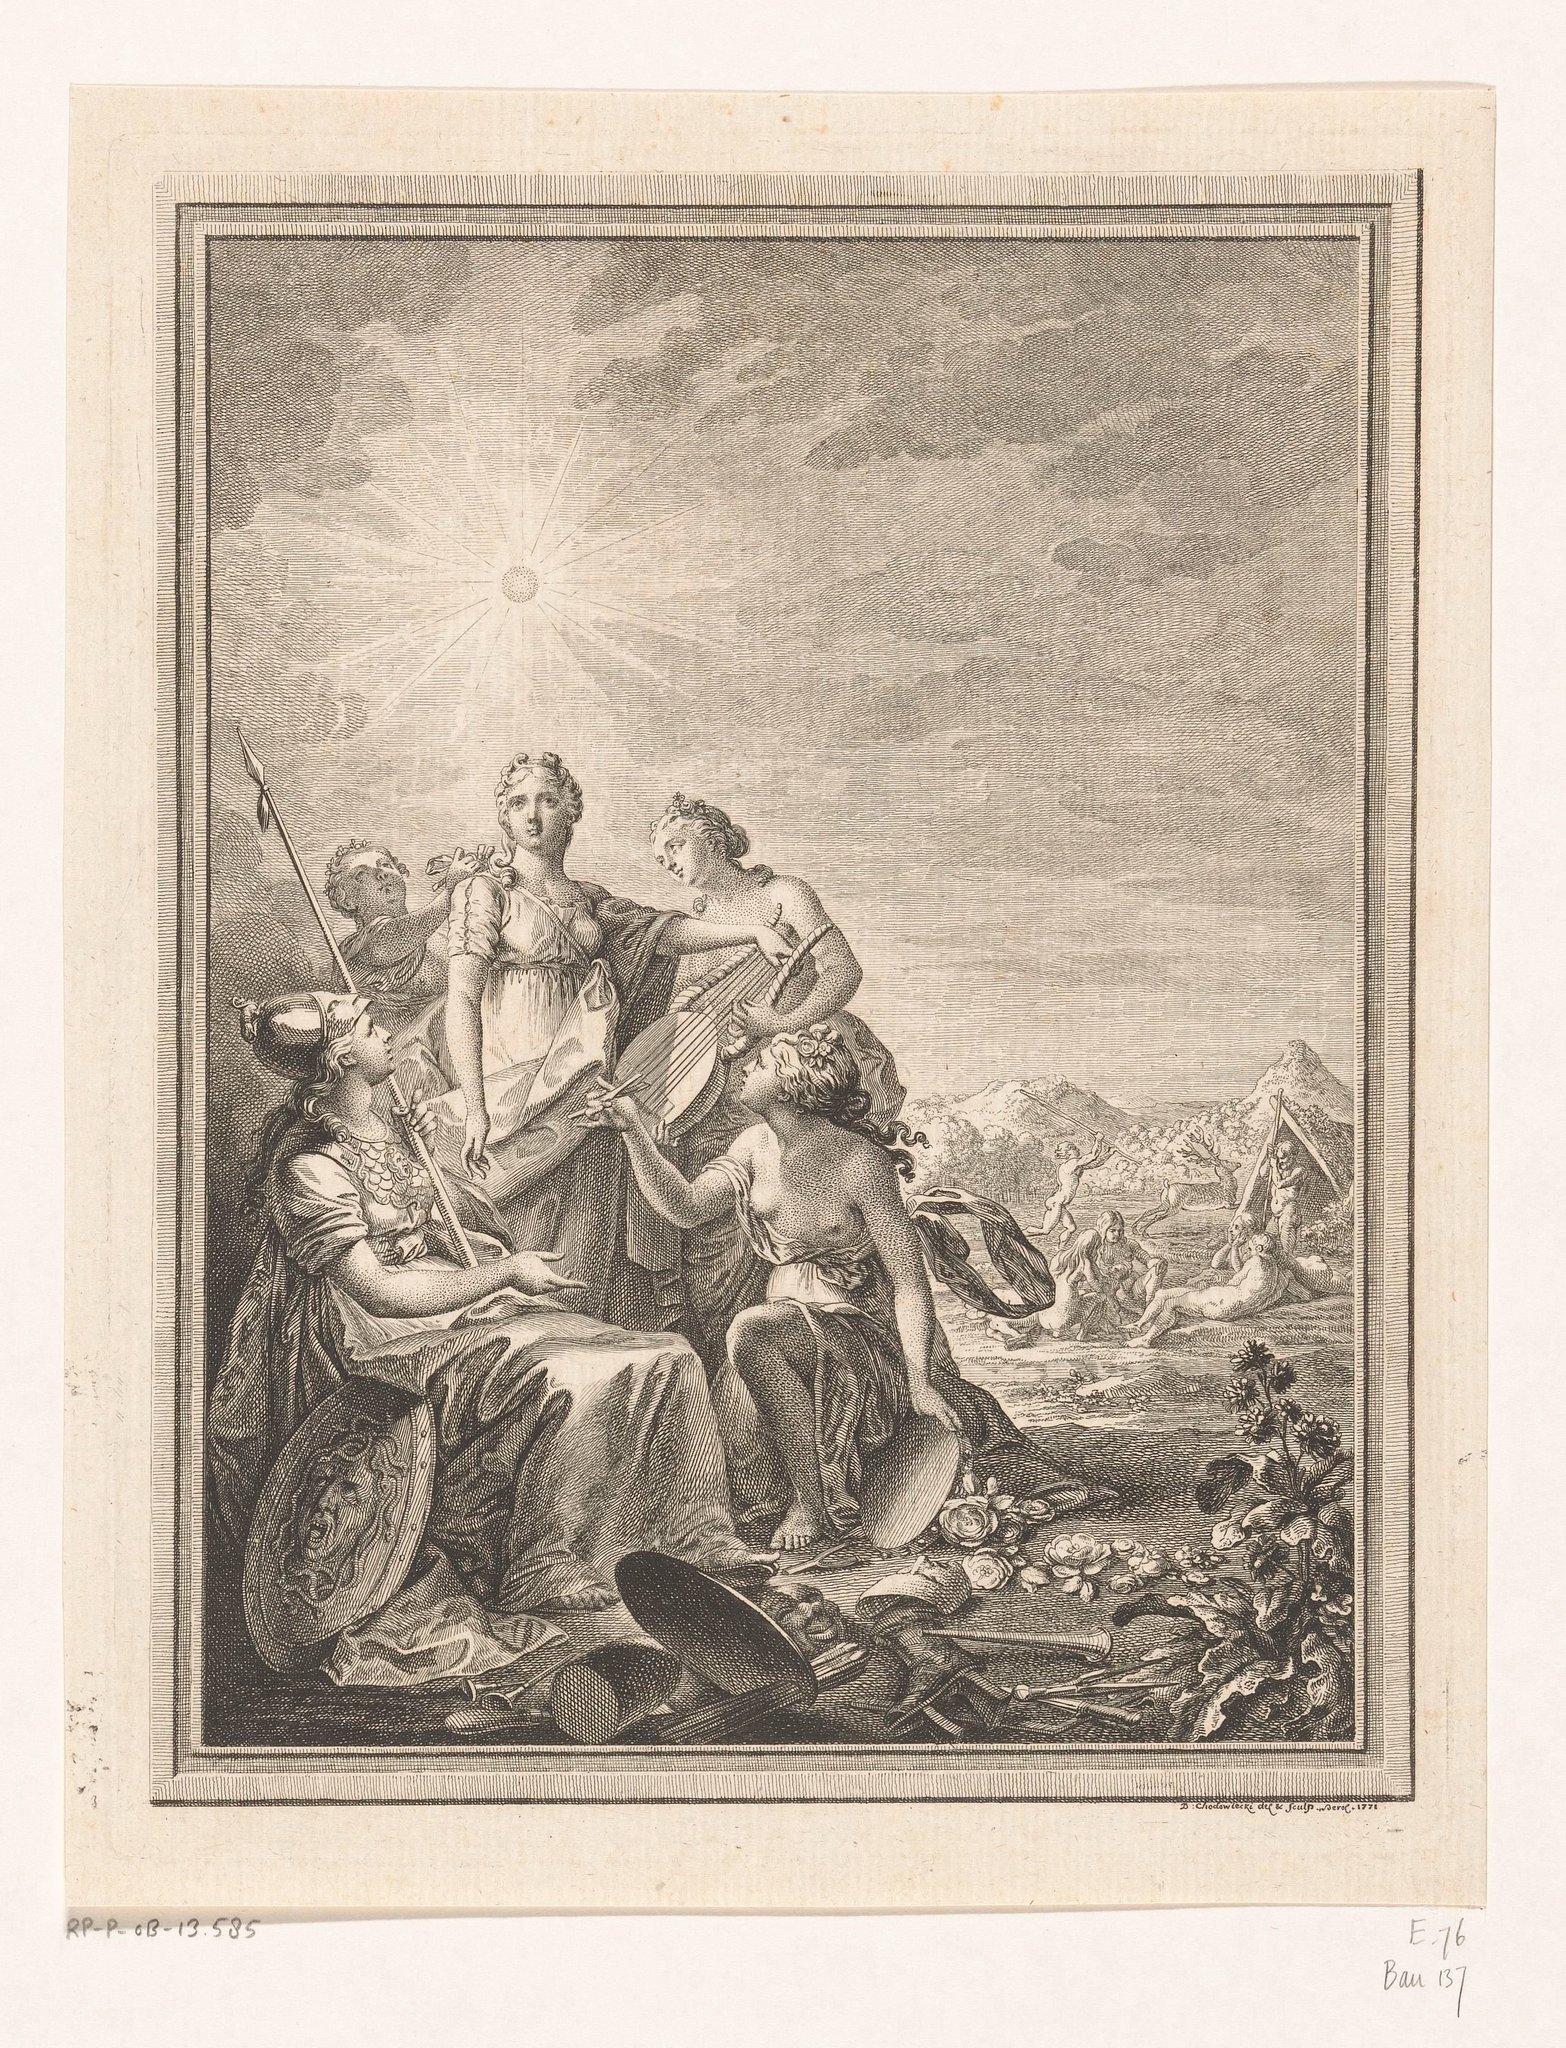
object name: print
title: Schoonheid met Minerva en de drie gratieën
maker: daniel nikolaus chodowiecki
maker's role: draughtsman, print maker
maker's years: 1726-1801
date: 1771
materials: paper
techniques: etching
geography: berlin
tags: (story of) diana (artemis), stag-hunting, (story of) minerva (pallas, athena), beauty; 'bellezza' (ripa)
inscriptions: collector's mark: Lugt 2228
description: Ook gebruikt in: Sulzer, Johann Georg. Allgemeine Theorie der schönen Künste. Leipzig: erven M.G. Weidmann en Reich, 1771, dl. 1.